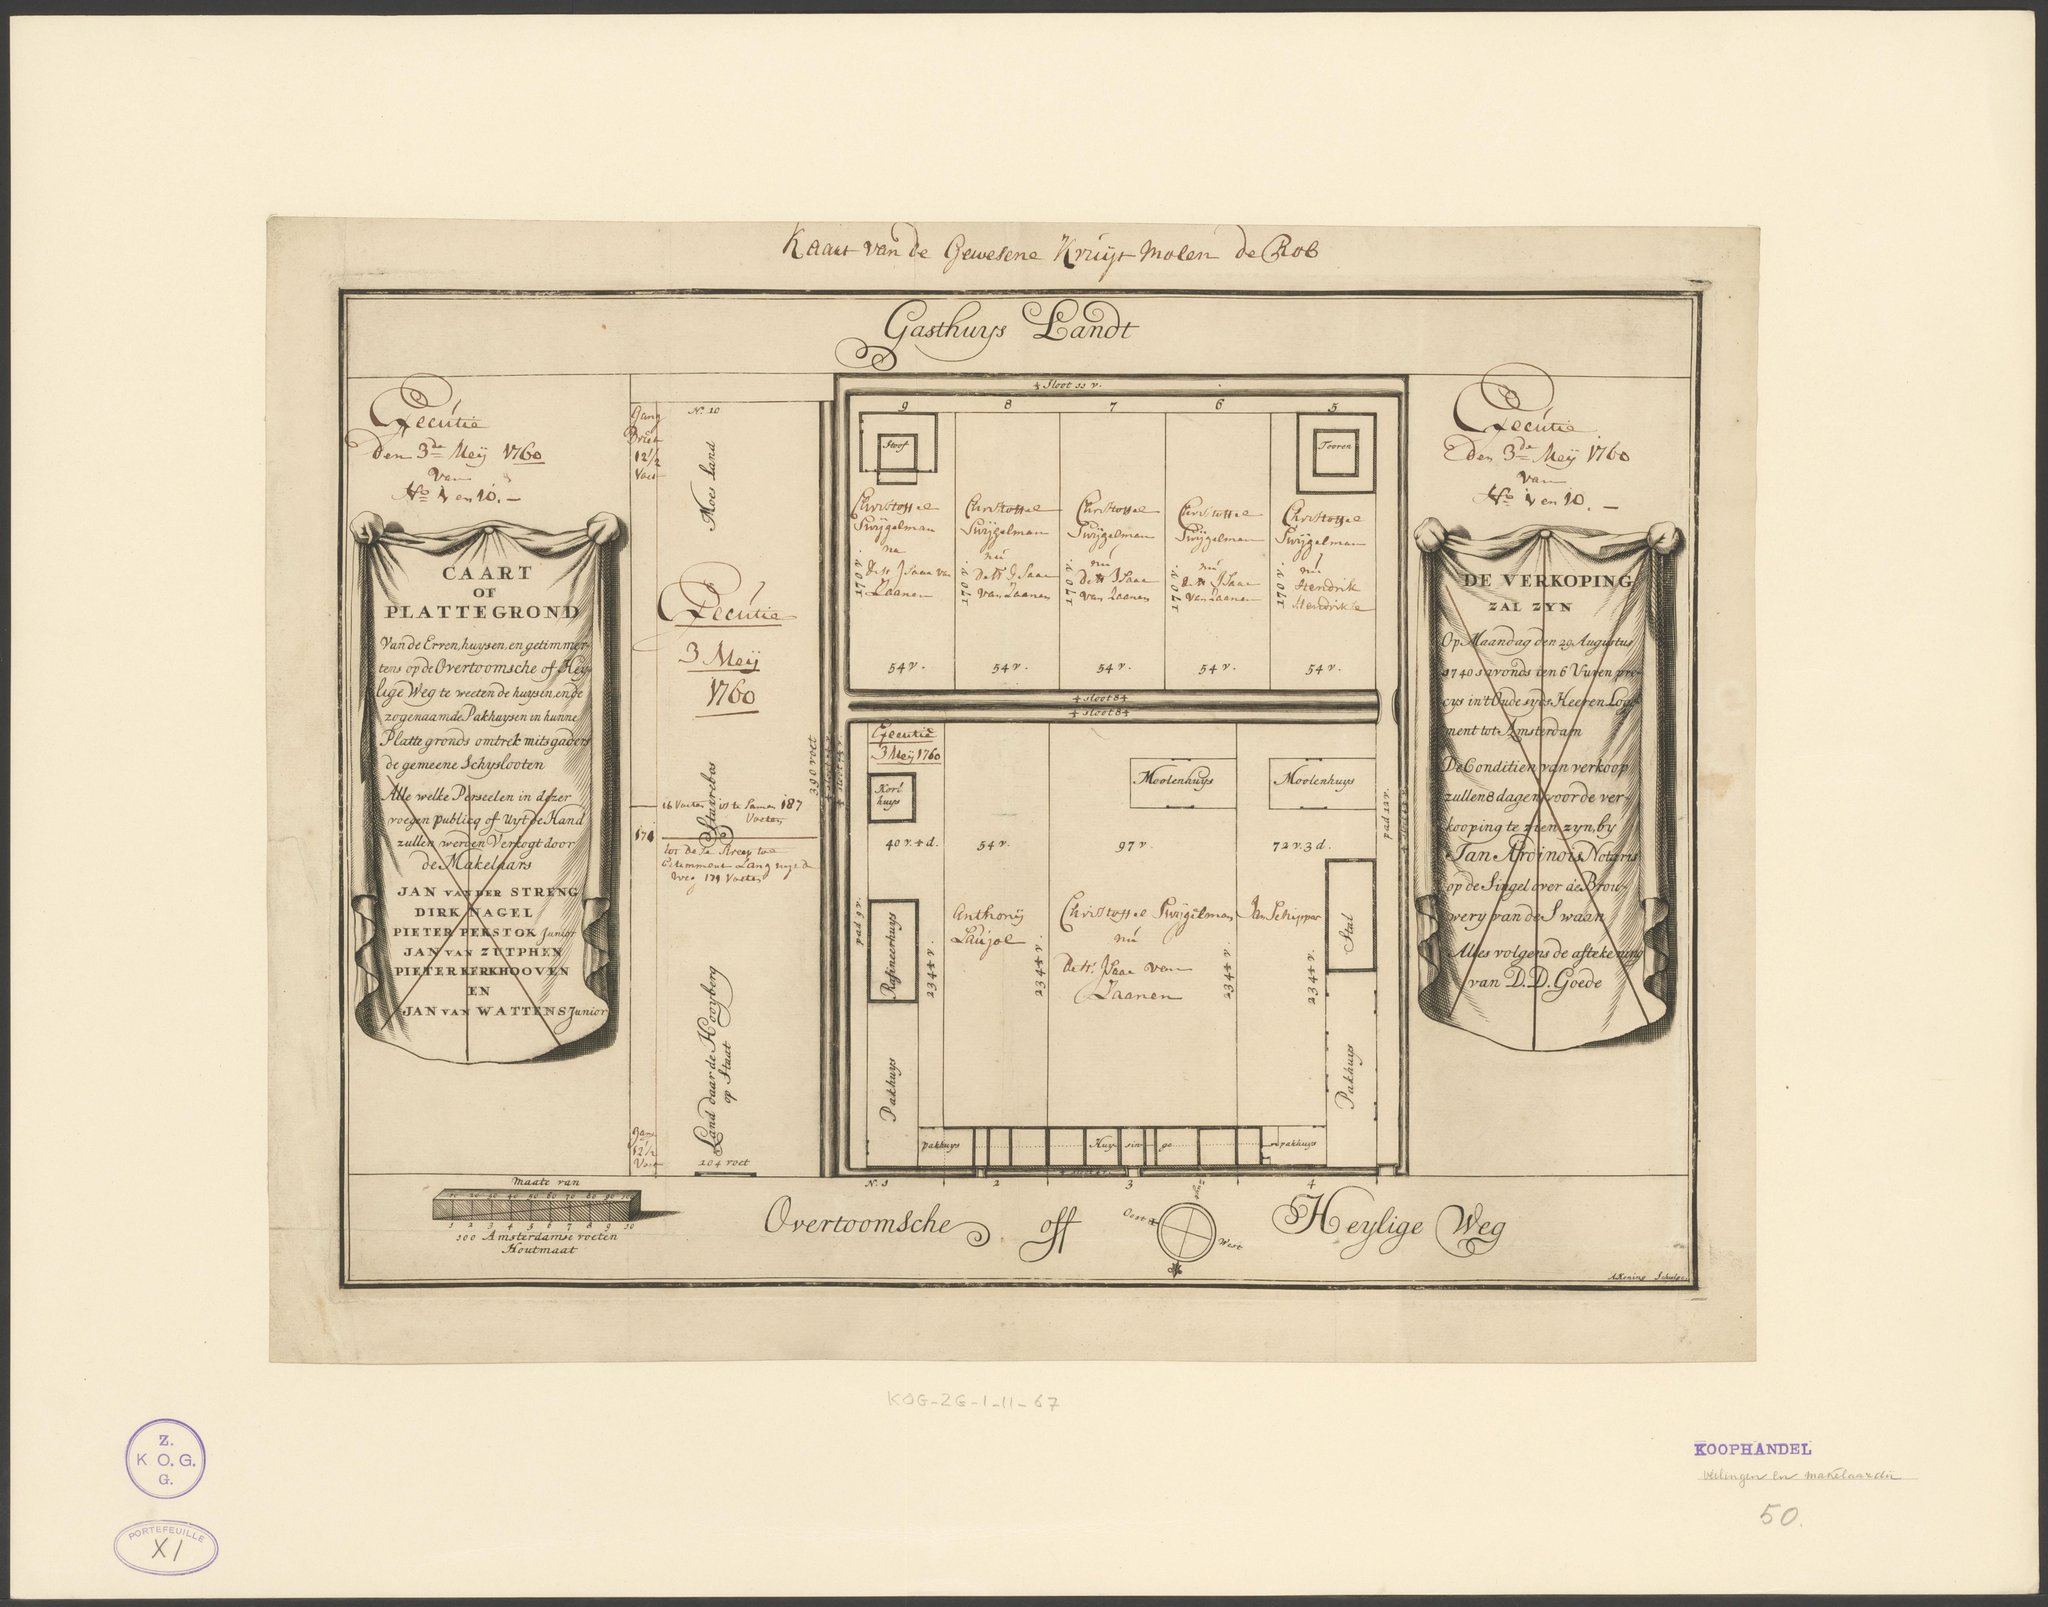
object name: print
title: Plattegrond en verdeling van percelen van het Gasthuis Land op de Heilige Weg te Amsterdam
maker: a. koning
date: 1760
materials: paper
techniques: engraving, writing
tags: plan ~ architecture, merchant, salesman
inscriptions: collector's mark: Lugt 1641, stamp, stamp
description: Plattegrond en verdeling van percelen van het Gasthuis Land op de Heilige Weg in Amsterdam. De namen van de makelaars die de percelen verkopen zijn doorgestreept. Onderwerpsrubrieken binnen de Atlas Zeden en Gewoonten: Handel, nijverheid en verkeer, Koophandel, Veilingen, Makelaardij en Verzekeringswezen. Kamers te huur.